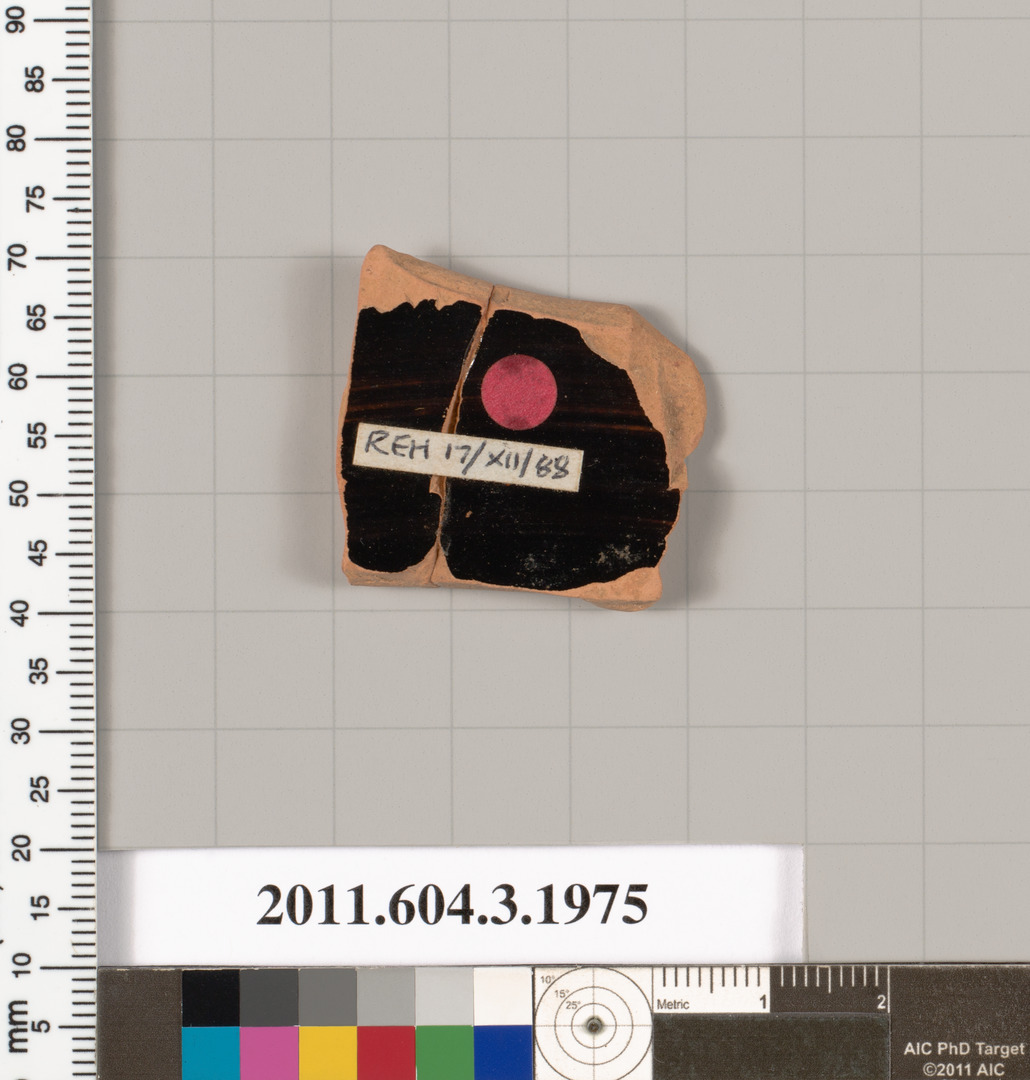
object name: kylix fragment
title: Terracotta fragment of a kylix (drinking cup)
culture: greek, attic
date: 600-501 BCE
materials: terracotta